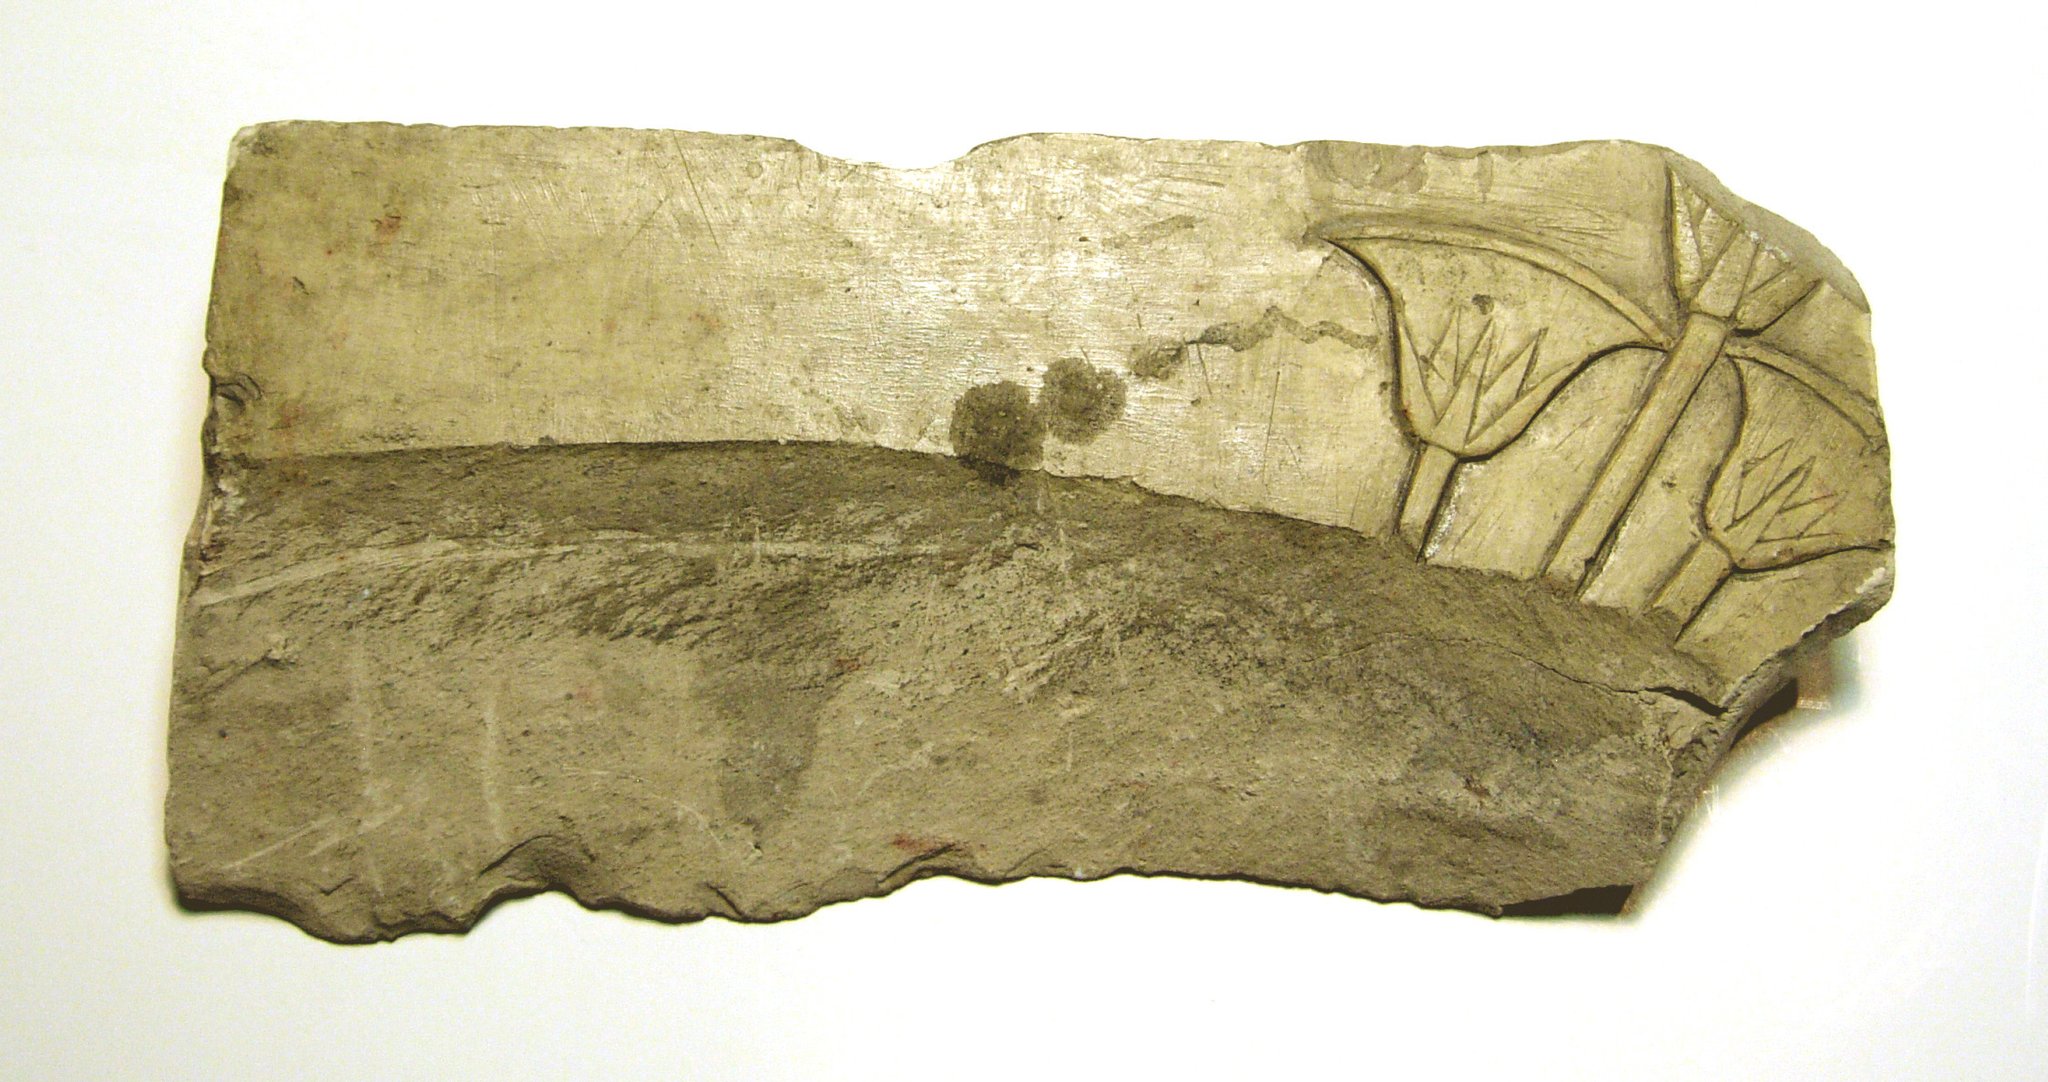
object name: relief, tomb of nespekashuty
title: Raised relief fragment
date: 664-610 BCE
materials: limestone, varnish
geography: egypt